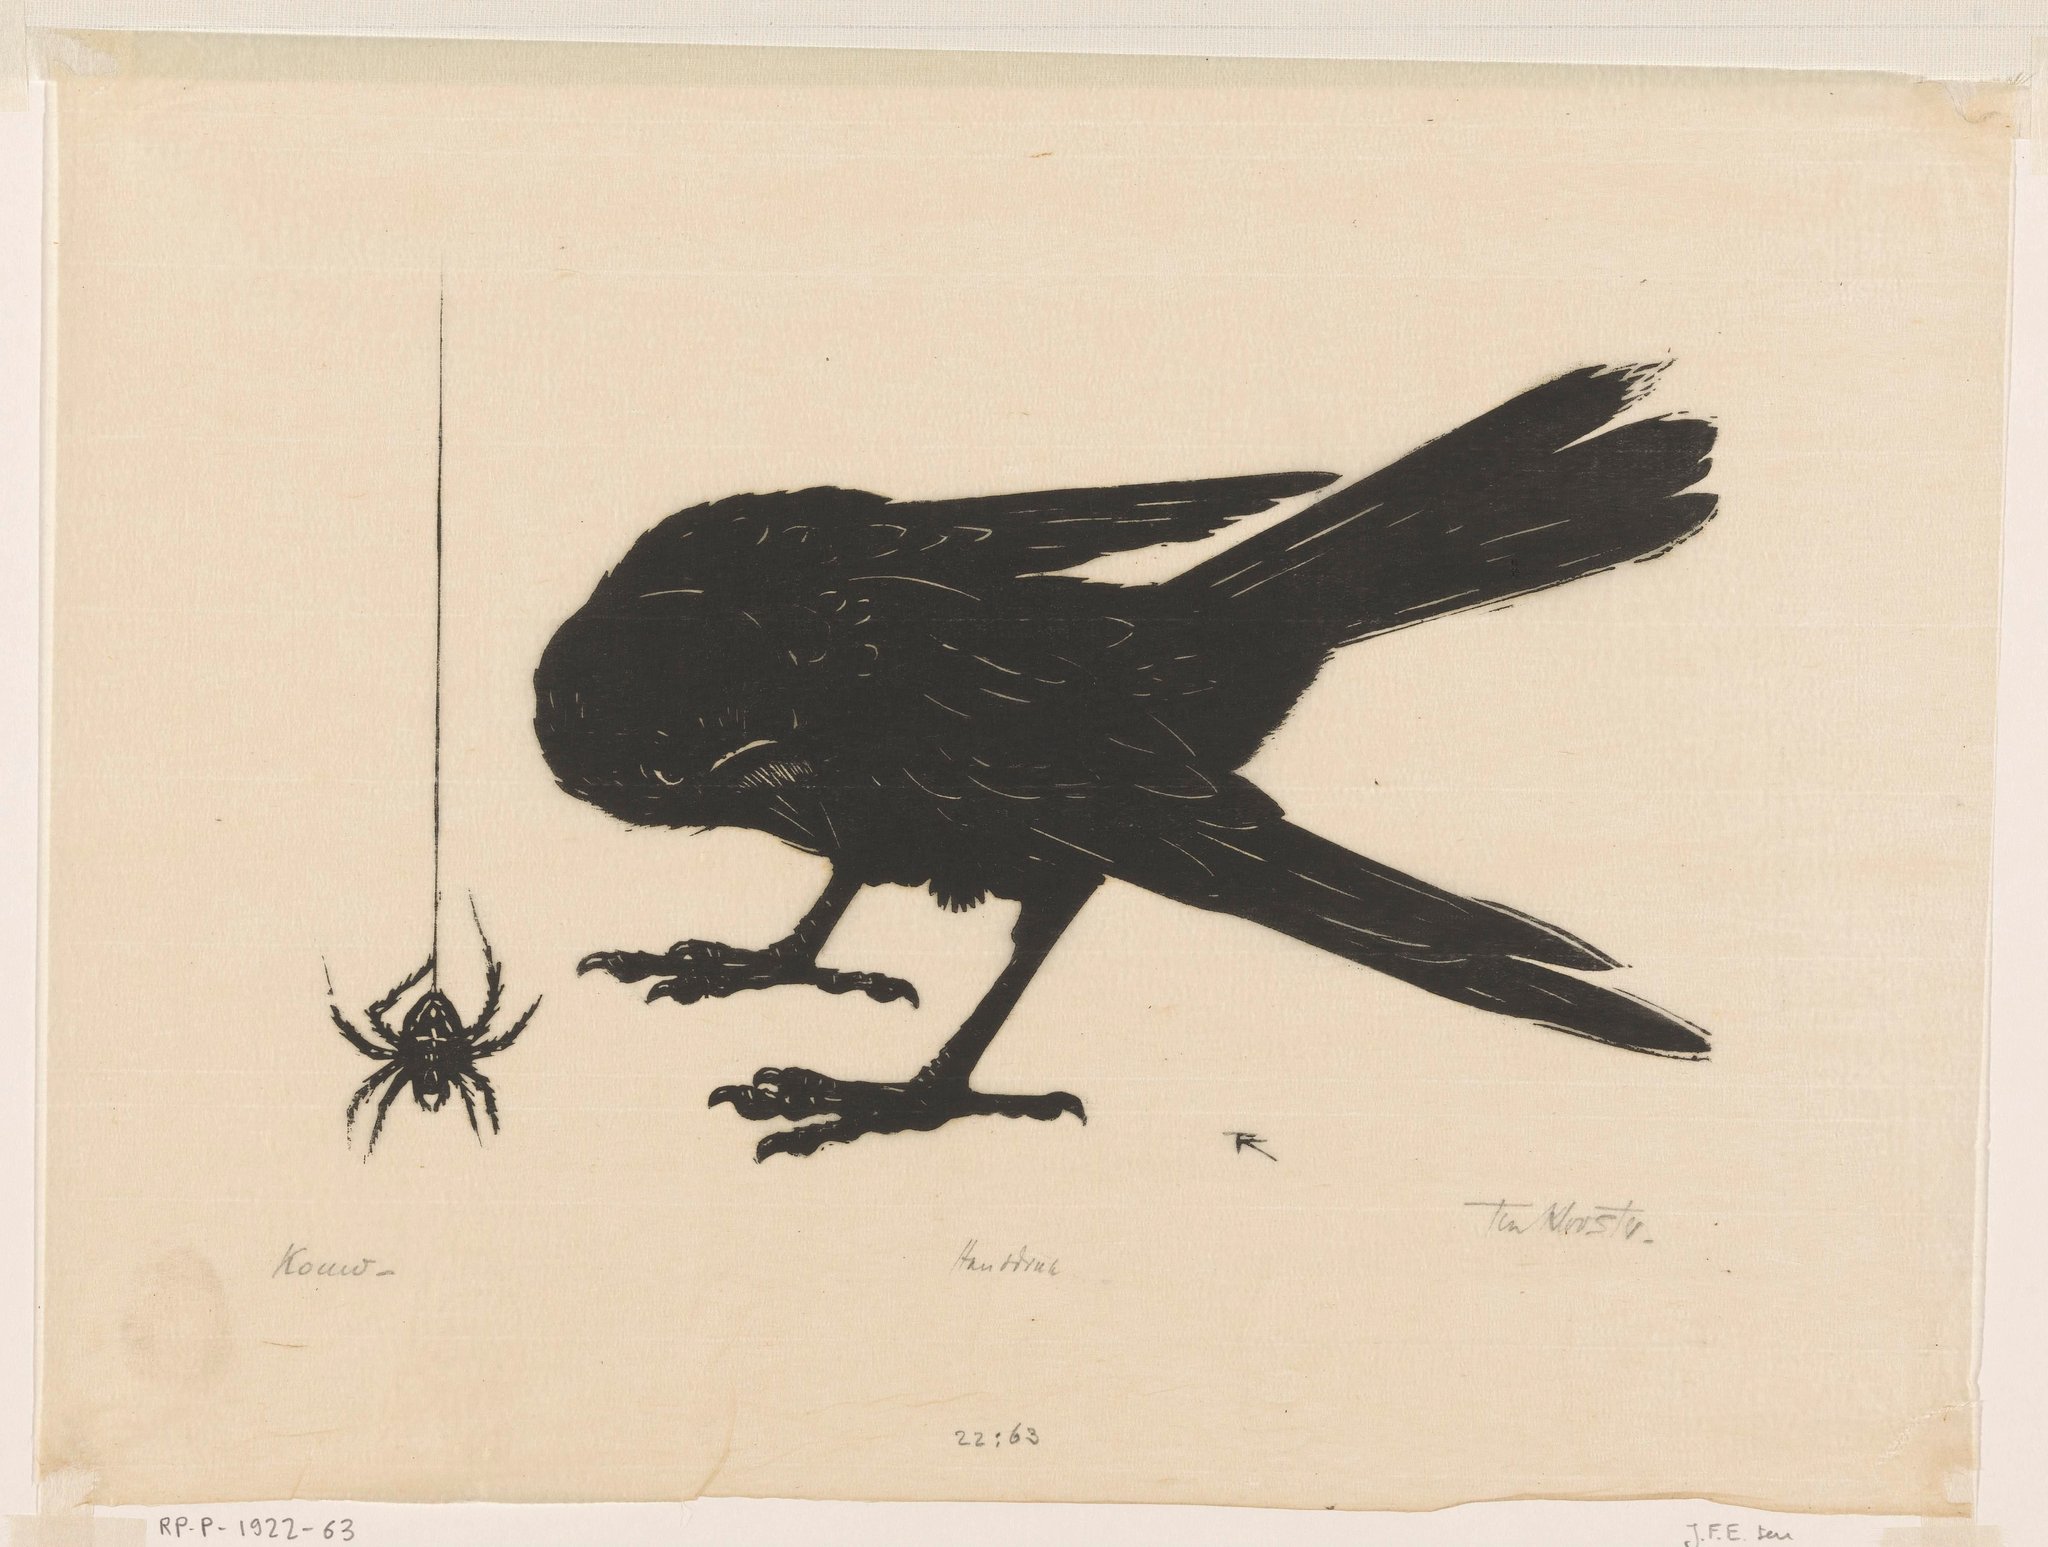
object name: print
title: Kauw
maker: johannes frederik engelbert ten klooster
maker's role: draughtsman, print maker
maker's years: 1873-1940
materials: paper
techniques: woodcut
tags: song-birds: jackdaw, spiders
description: Een kauw genaamd Gerrit bij een kruisspin die aan een spinnendraad hangt.